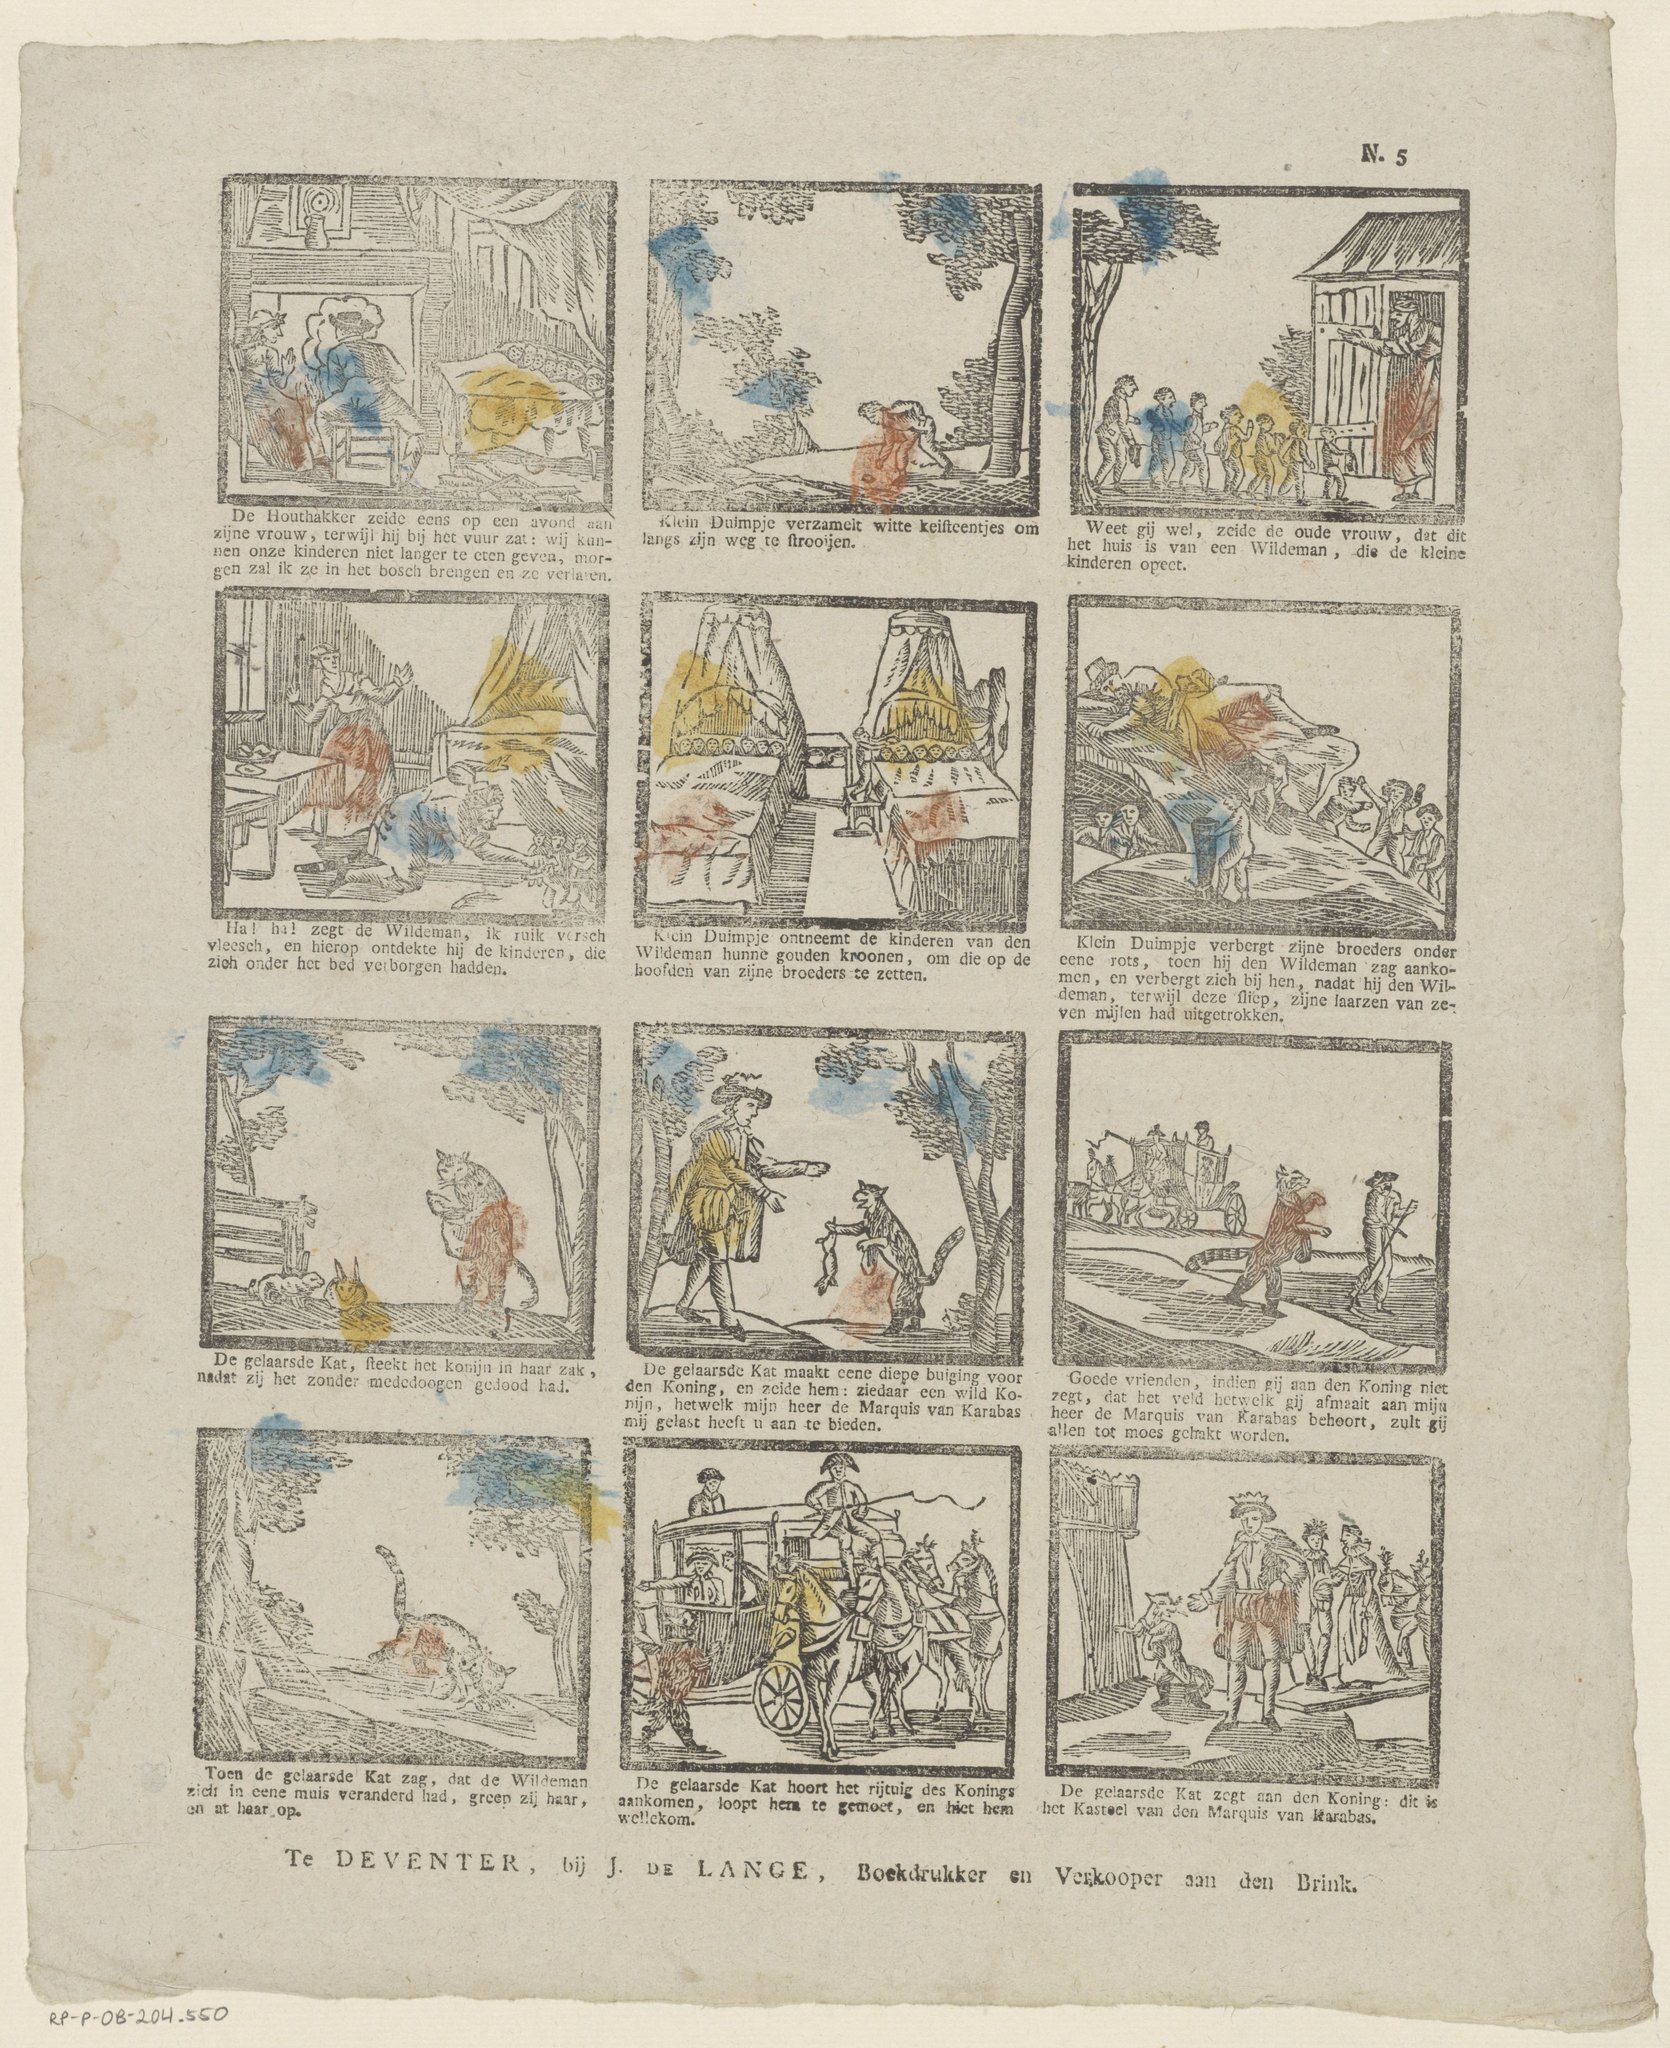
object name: popular print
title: Klein Duimpje en de Gelaarsde kat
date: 1822-1849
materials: paper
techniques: colour, letterpress printing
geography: netherlands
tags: tales and fairy tales: little thumbling, tales and fairy tales: puss in boots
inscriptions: collector's mark: Lugt 2760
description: Blad met 12 voorstellingen. Boven zes voorstellingen uit het sprookje van Klein Duimpje. Onder zes voorstellingen uit het sprookje van de gelaarsde kat. Onder elke afbeelding een onderschrift. Genummerd rechtsboven: N. 5.